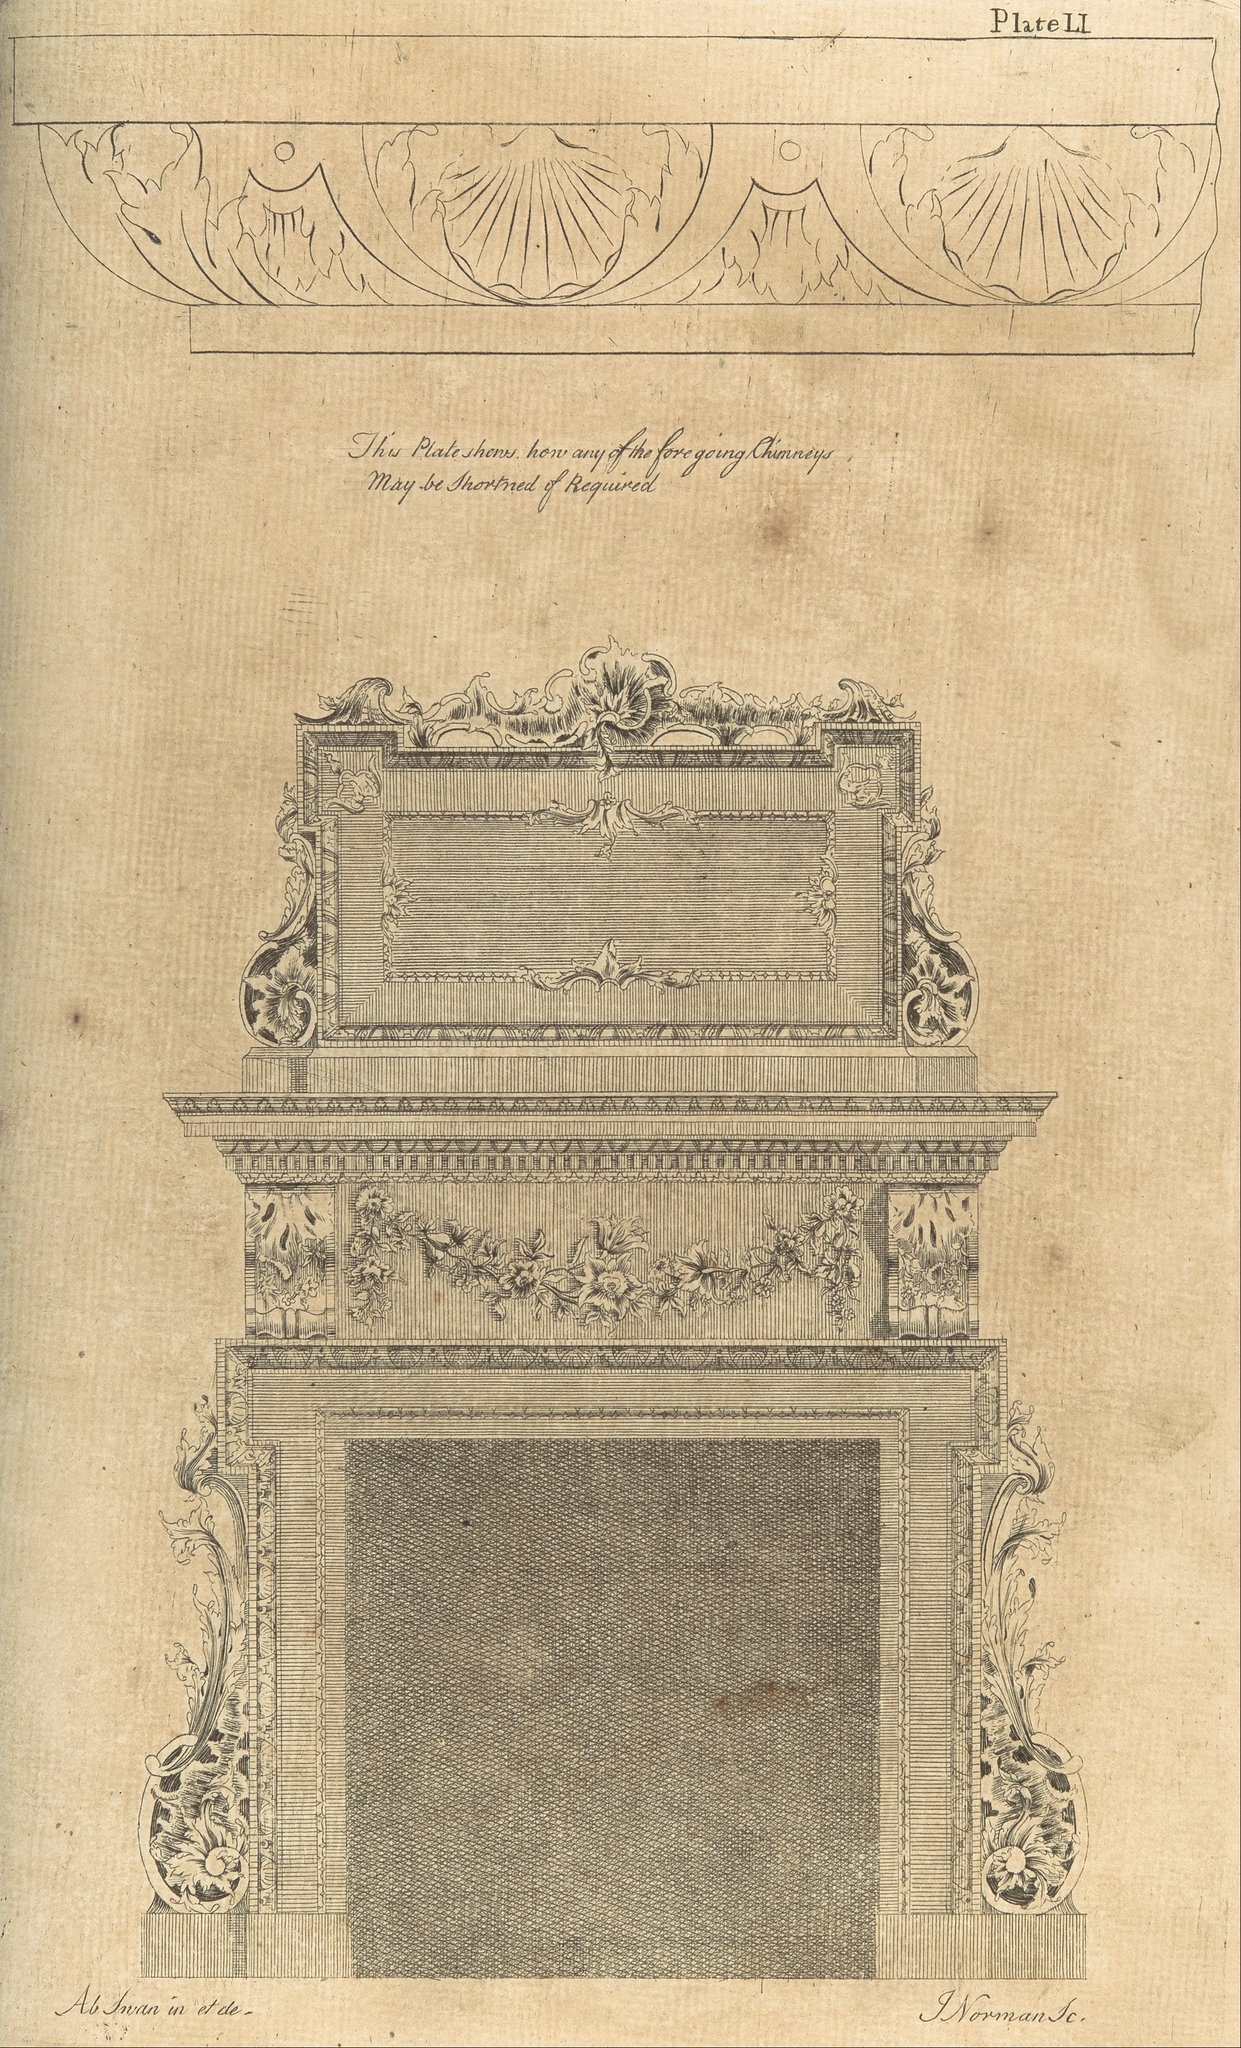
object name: book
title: The British Architect; or, the Builder's Treasury of Staircases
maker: abraham swan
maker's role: author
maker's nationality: british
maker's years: 1700-1800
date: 1775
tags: architecture